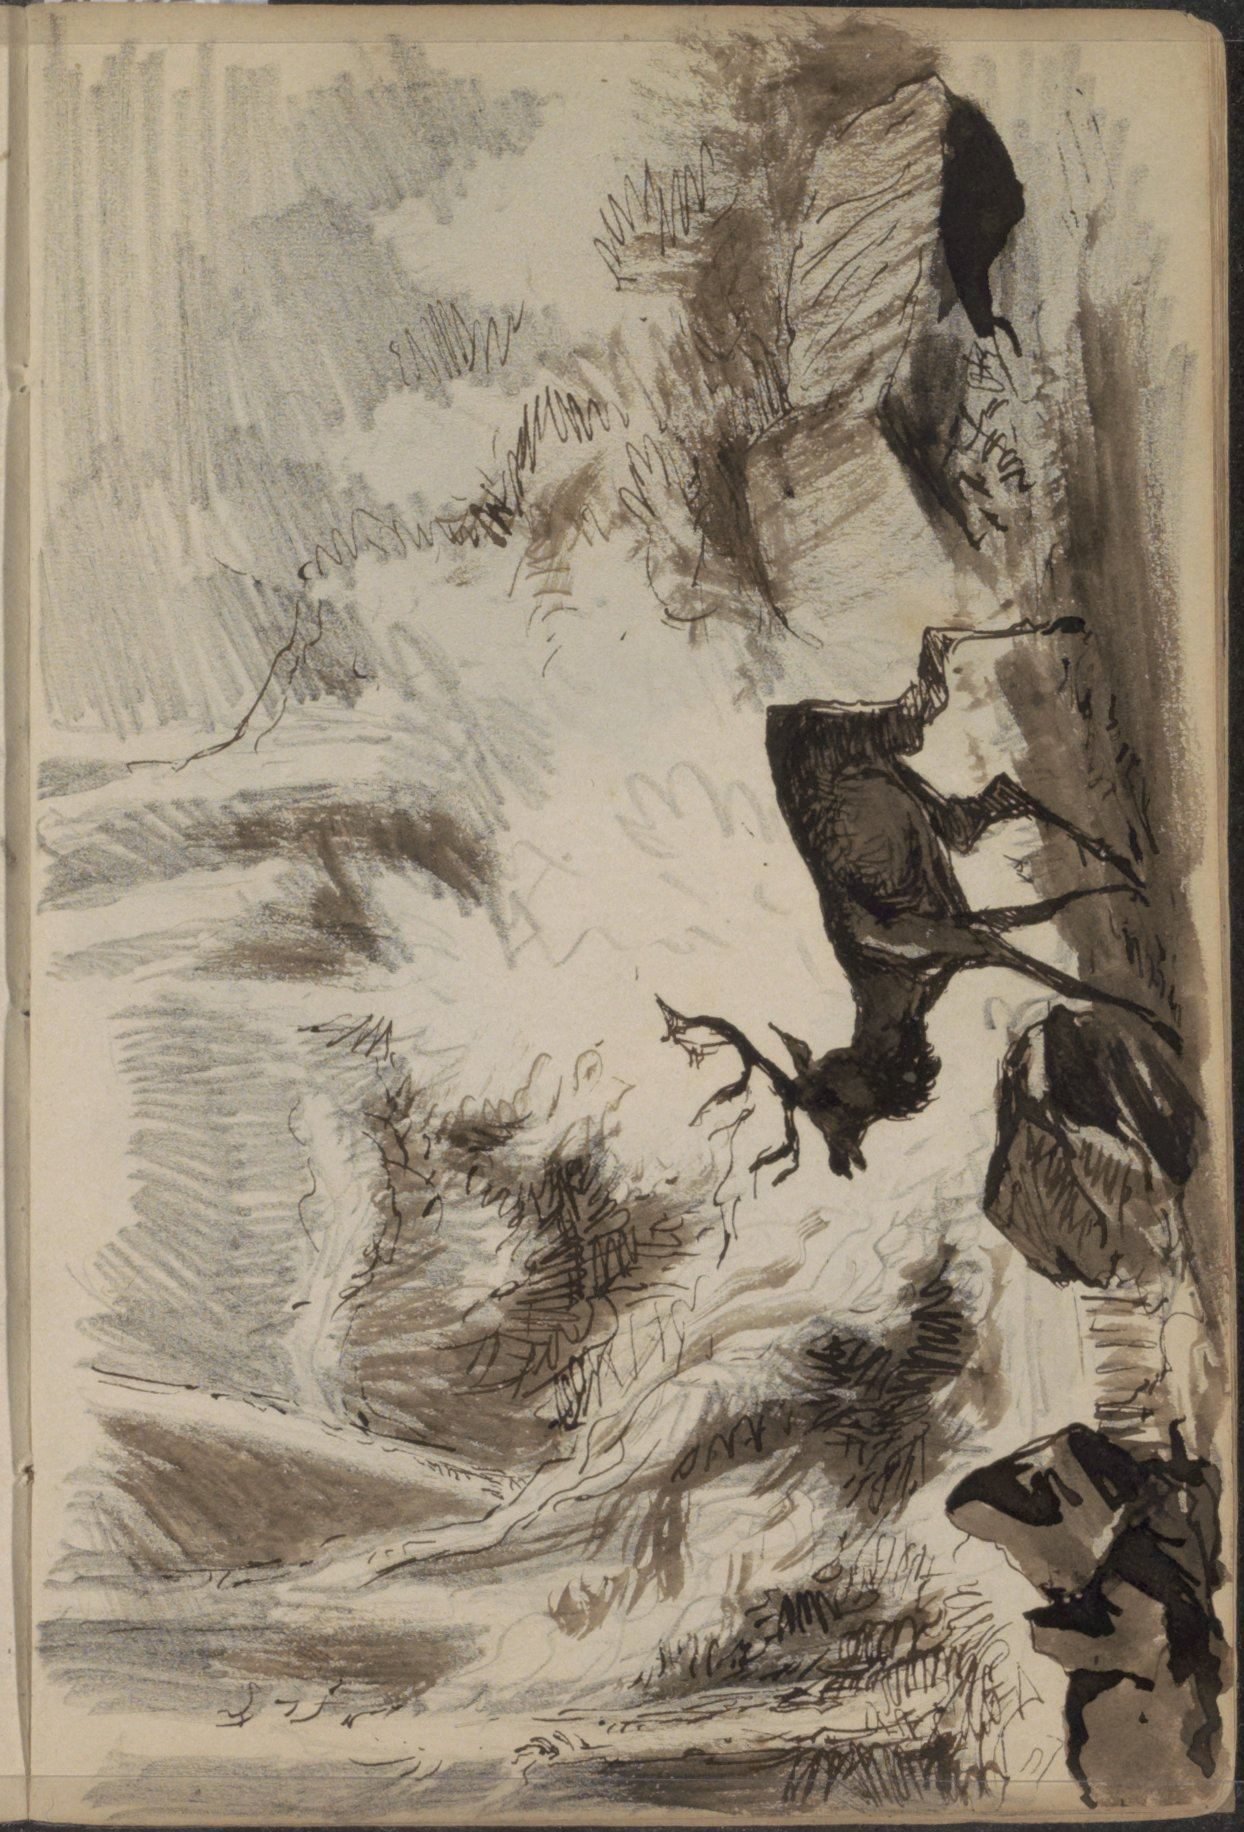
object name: sketchbook leaf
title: Landschap met een hert bij de rand van een beek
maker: johannes tavenraat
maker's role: draughtsman, painter, print maker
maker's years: 1809-1881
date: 1858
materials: ink, paper, pencil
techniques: brush, pen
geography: bohemia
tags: hoofed animals: deer, landscapes with waters, waterscapes, seascapes (in the temperate zone), boulder, stone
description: Blad 14 recto uit een schetsboek met 44 bladen.